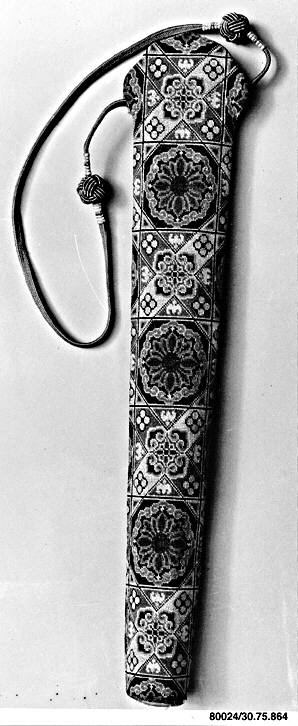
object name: fan holder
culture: chinese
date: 1701-1900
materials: silk